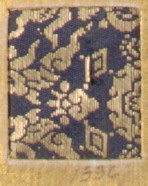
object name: piece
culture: japanese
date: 1701-1900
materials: silk